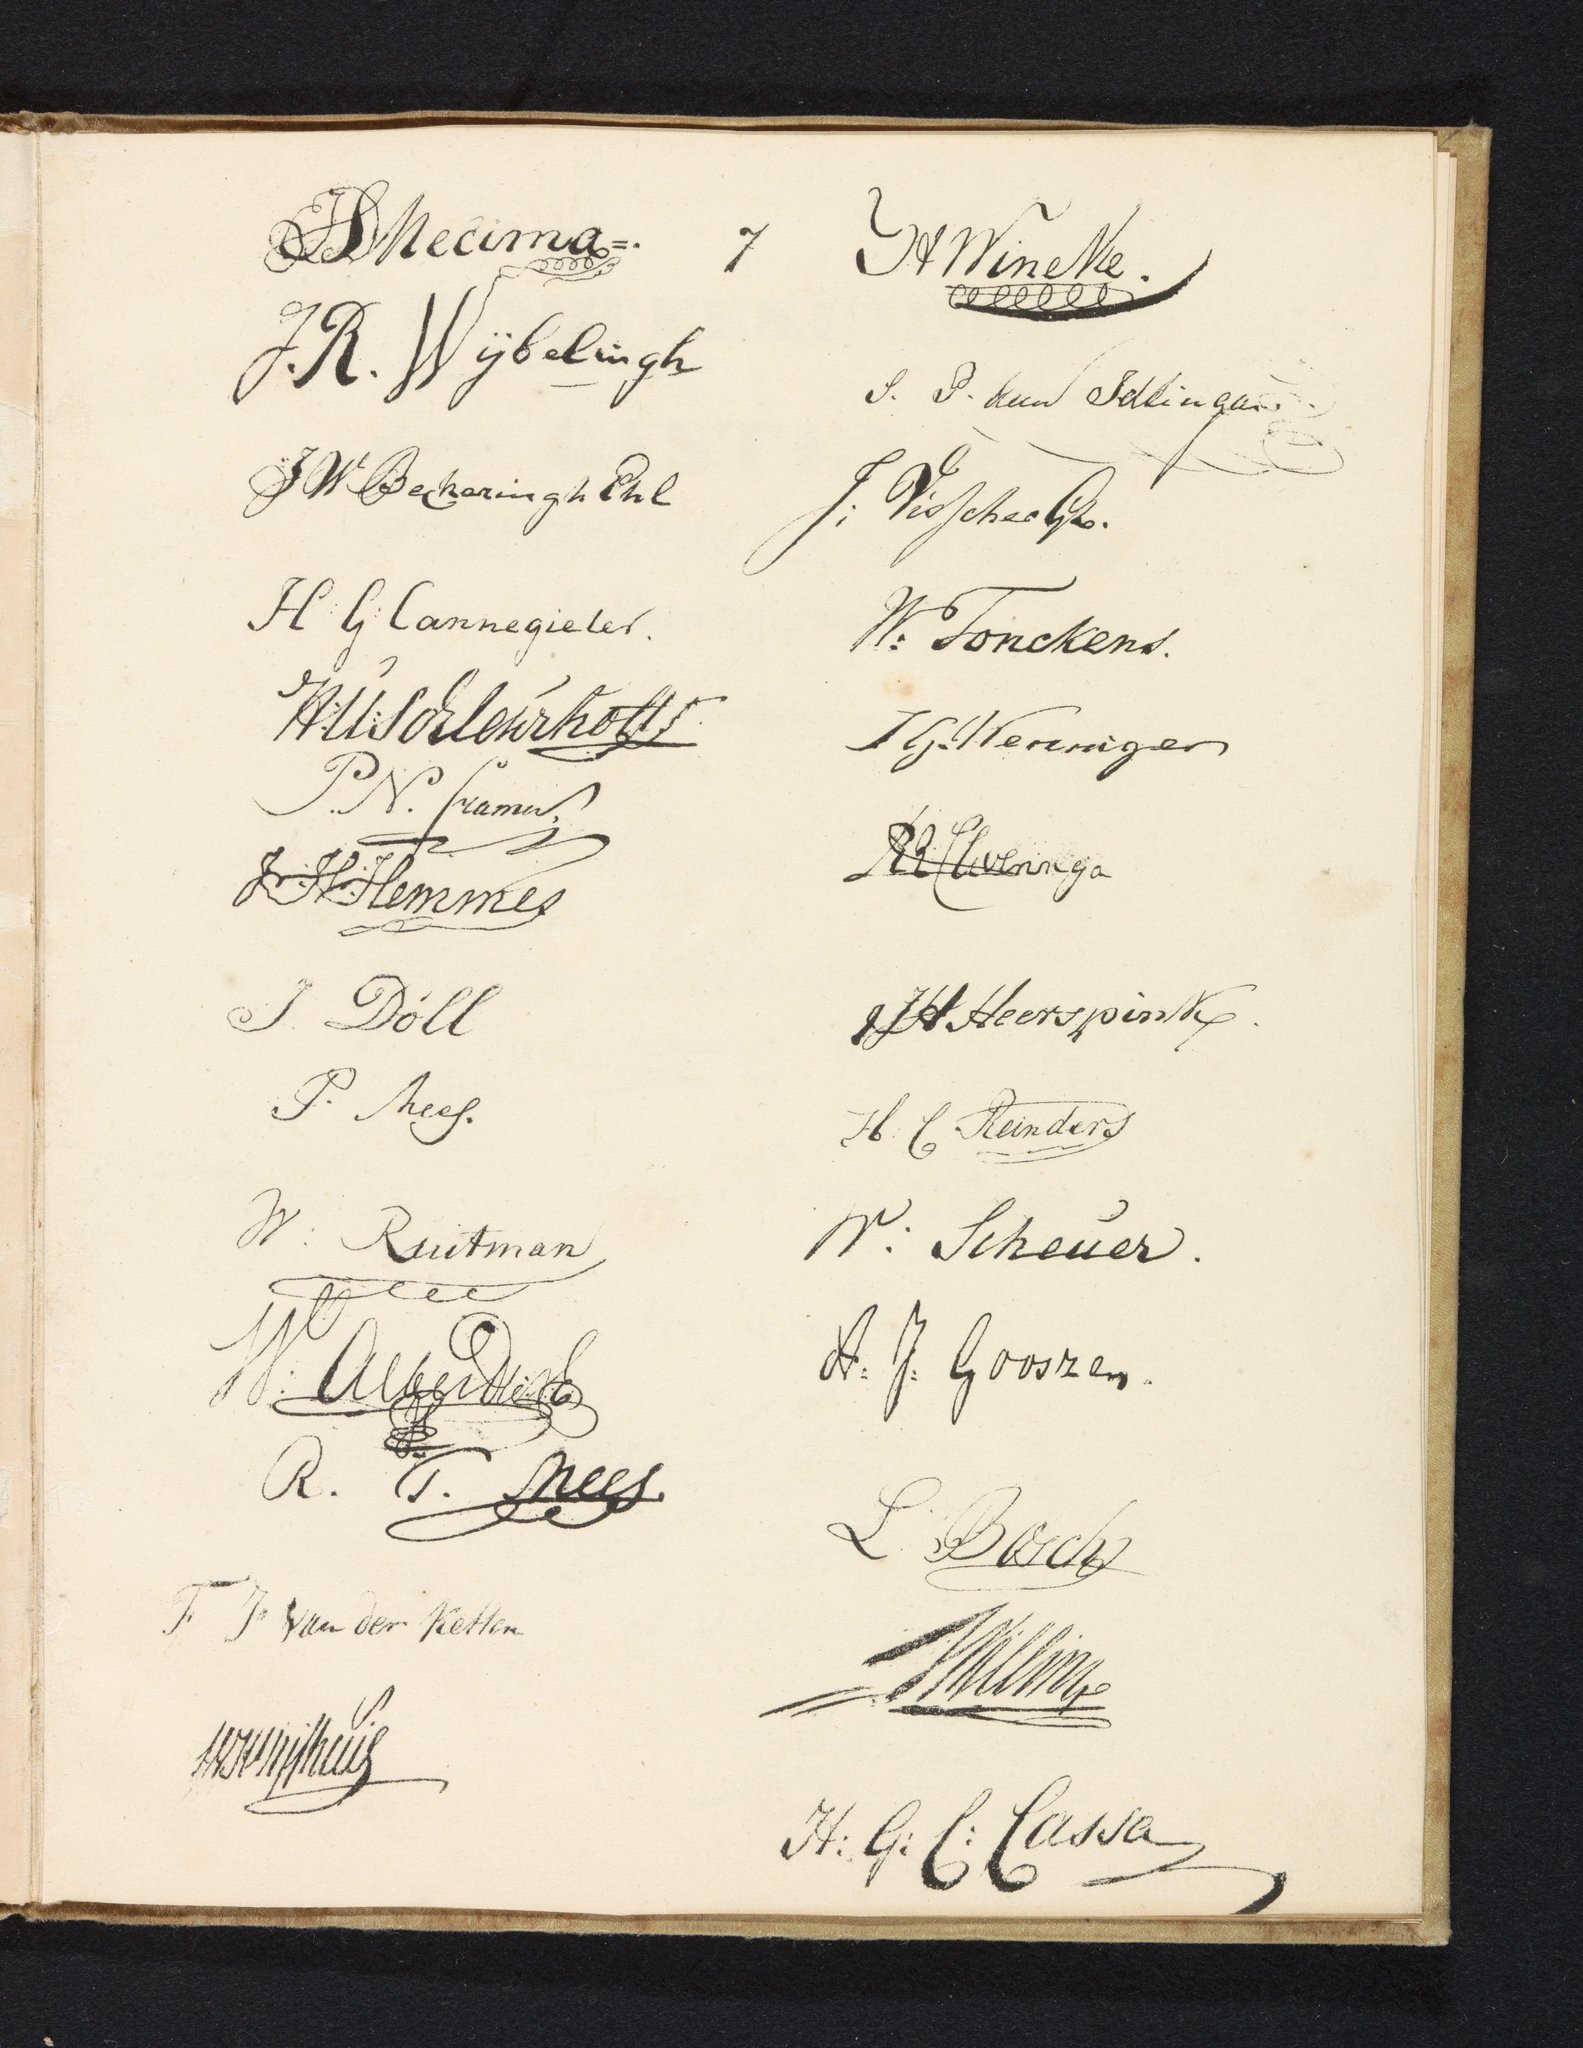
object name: print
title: Zevende blad met handtekeningen, 1830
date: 1807-1830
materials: paper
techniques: lithograph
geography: groningen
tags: title-page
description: Zevende blad met handtekeningen van de studenten in twee kolommen. Onderdeel van een boekje met de handtekeningen van de aanwezigen op het feest ter herdenking van de academische leeftijd op de Universiteit van Groningen op 1 juli 1830.